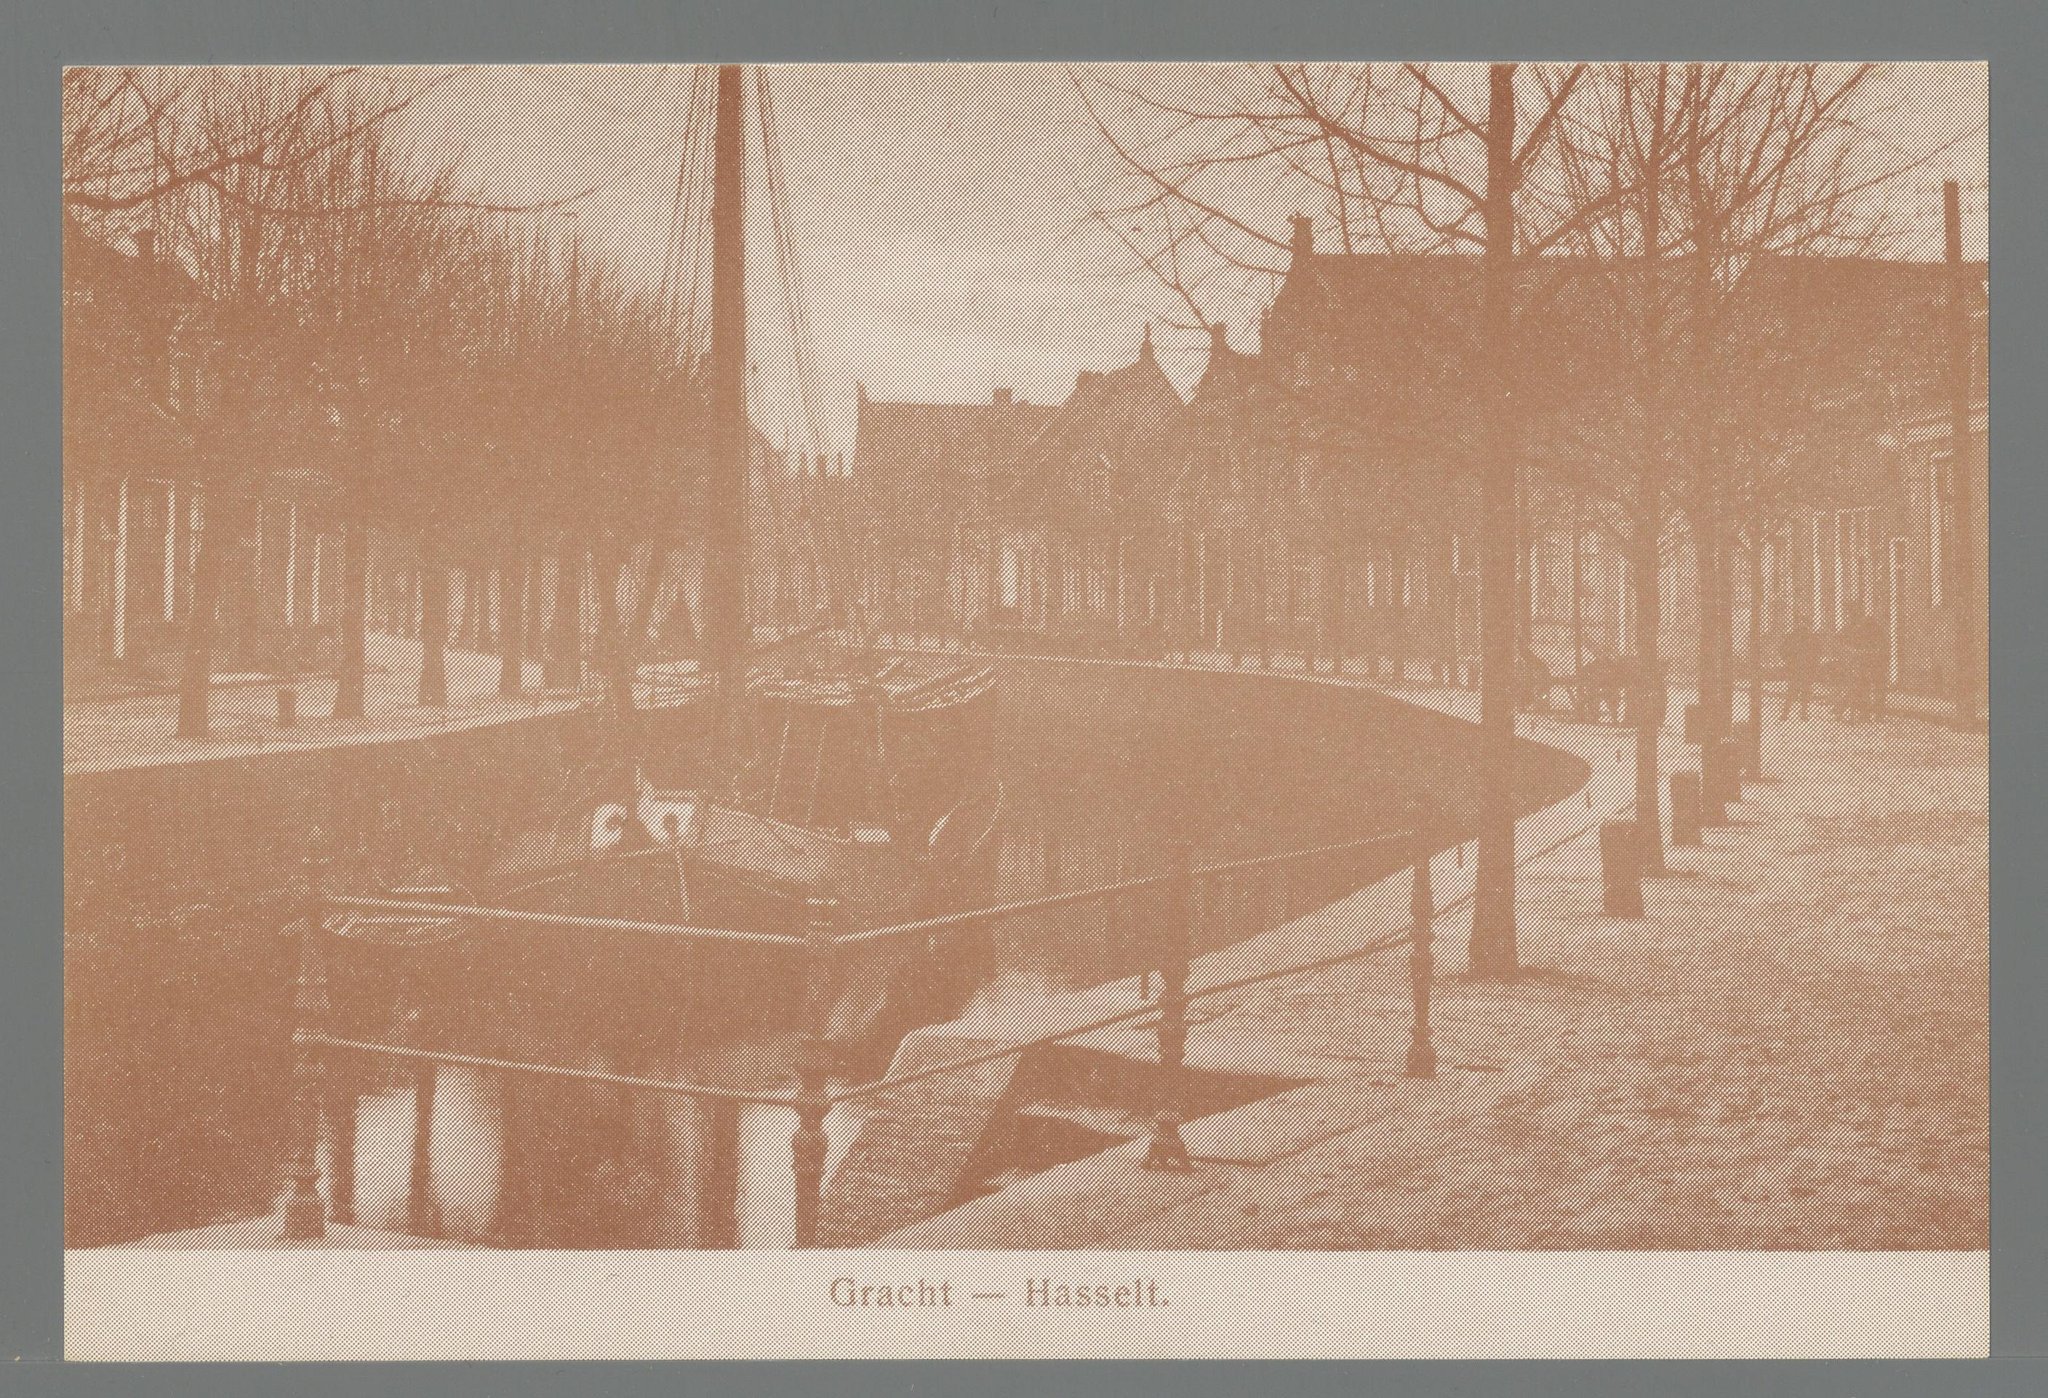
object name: ansichtkaart, prentbriefkaart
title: Heerengracht ca. 1910 (Hasselt)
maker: Anonymous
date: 1958-2021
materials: cardboard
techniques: autotype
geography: hasselt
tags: sailing-ship, sailing-boat, canal, street